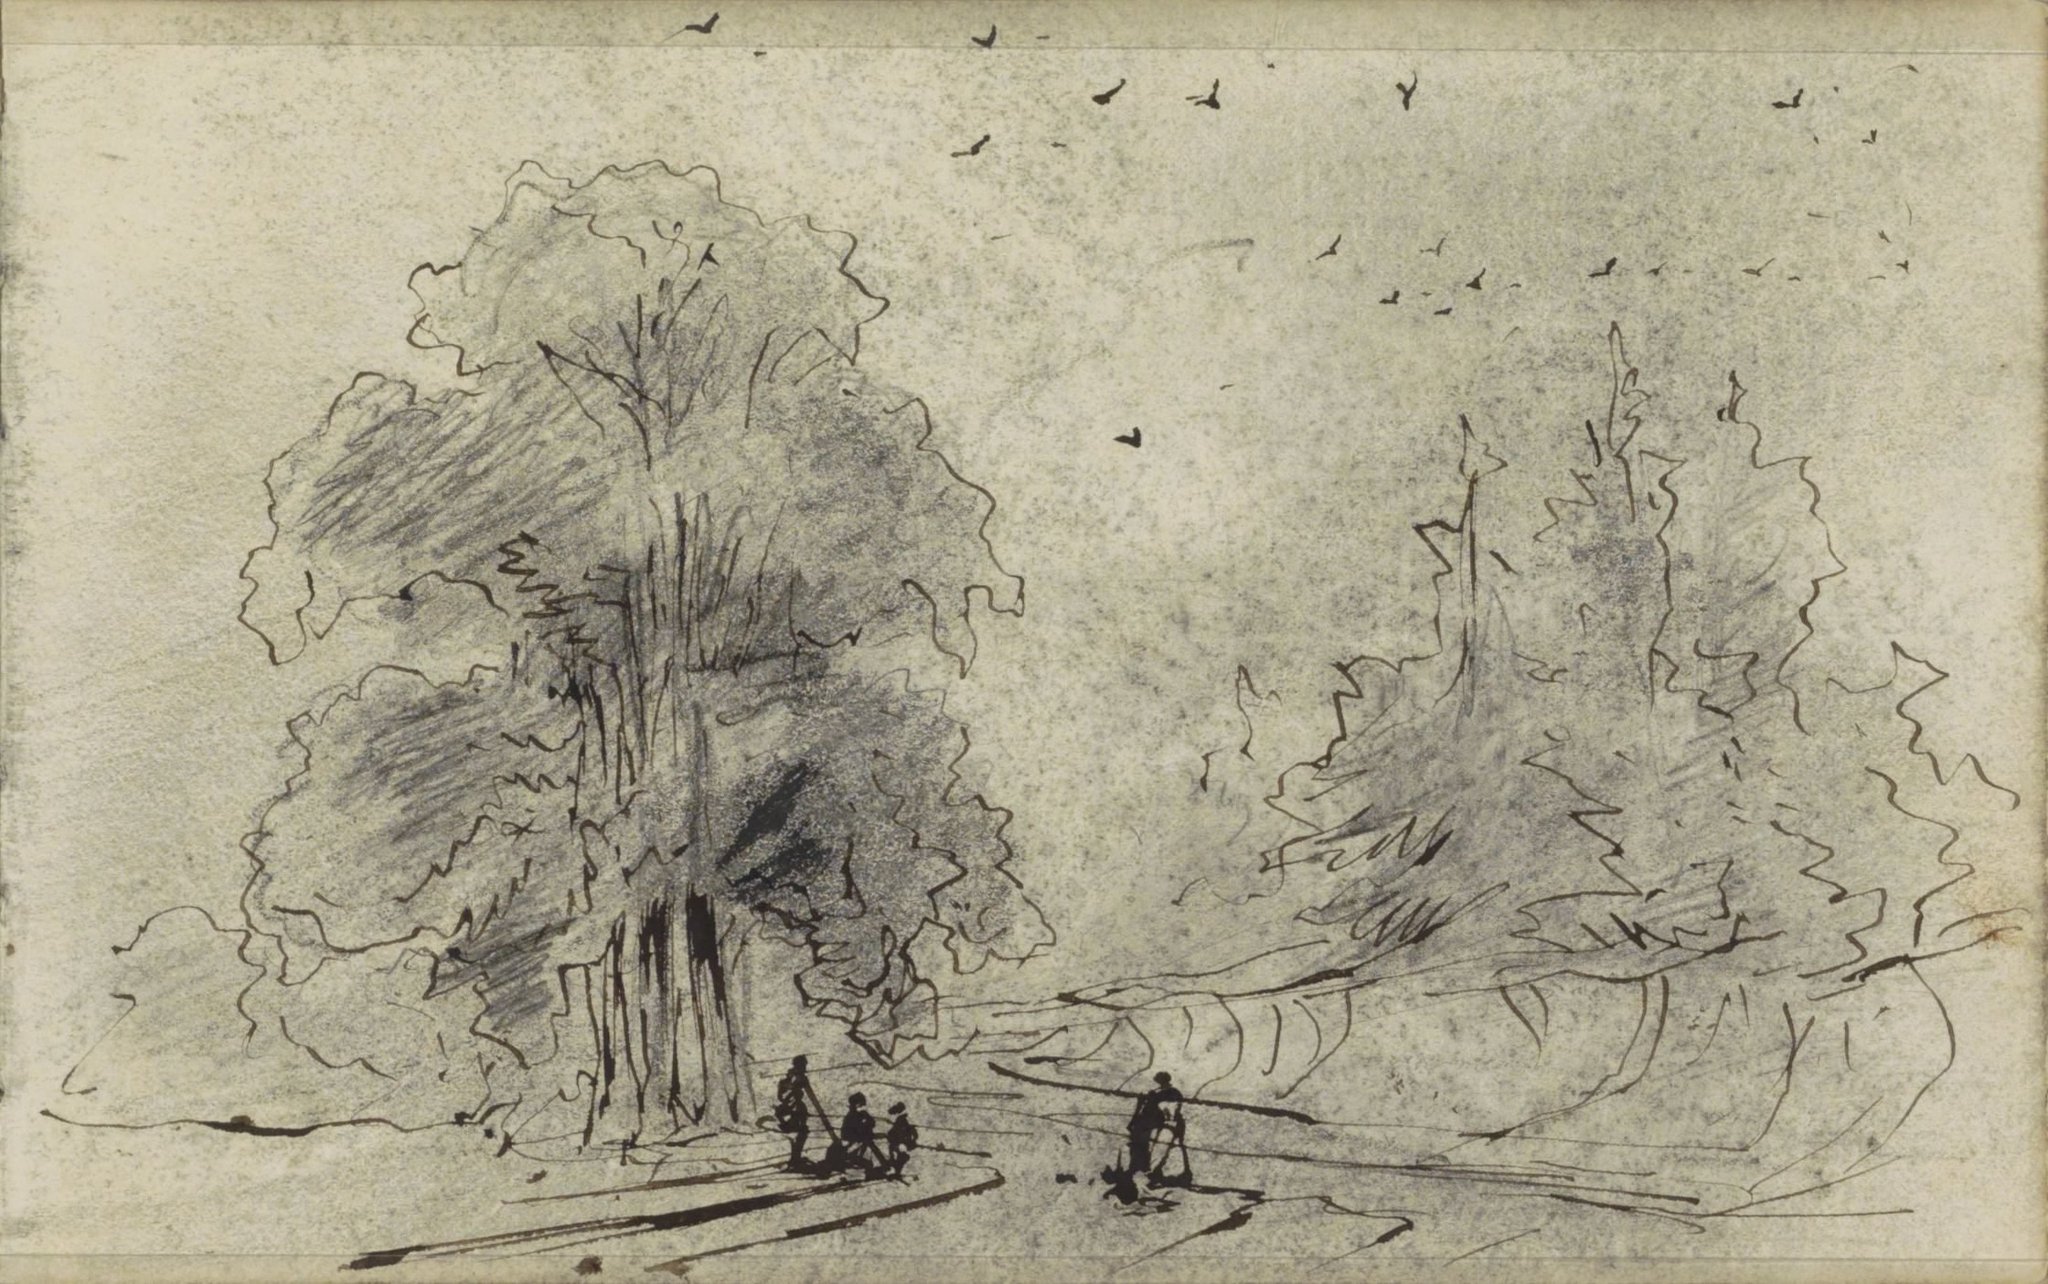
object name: sketchbook leaf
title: Boomachtig landschap met figuren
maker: johannes tavenraat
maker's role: draughtsman, painter, print maker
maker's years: 1809-1881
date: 1839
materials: paper, pencil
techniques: pen, stumping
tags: trees, landscapes (+ landscape with figures, staffage)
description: Blad 8 recto uit een schetsboek met 37 bladen.